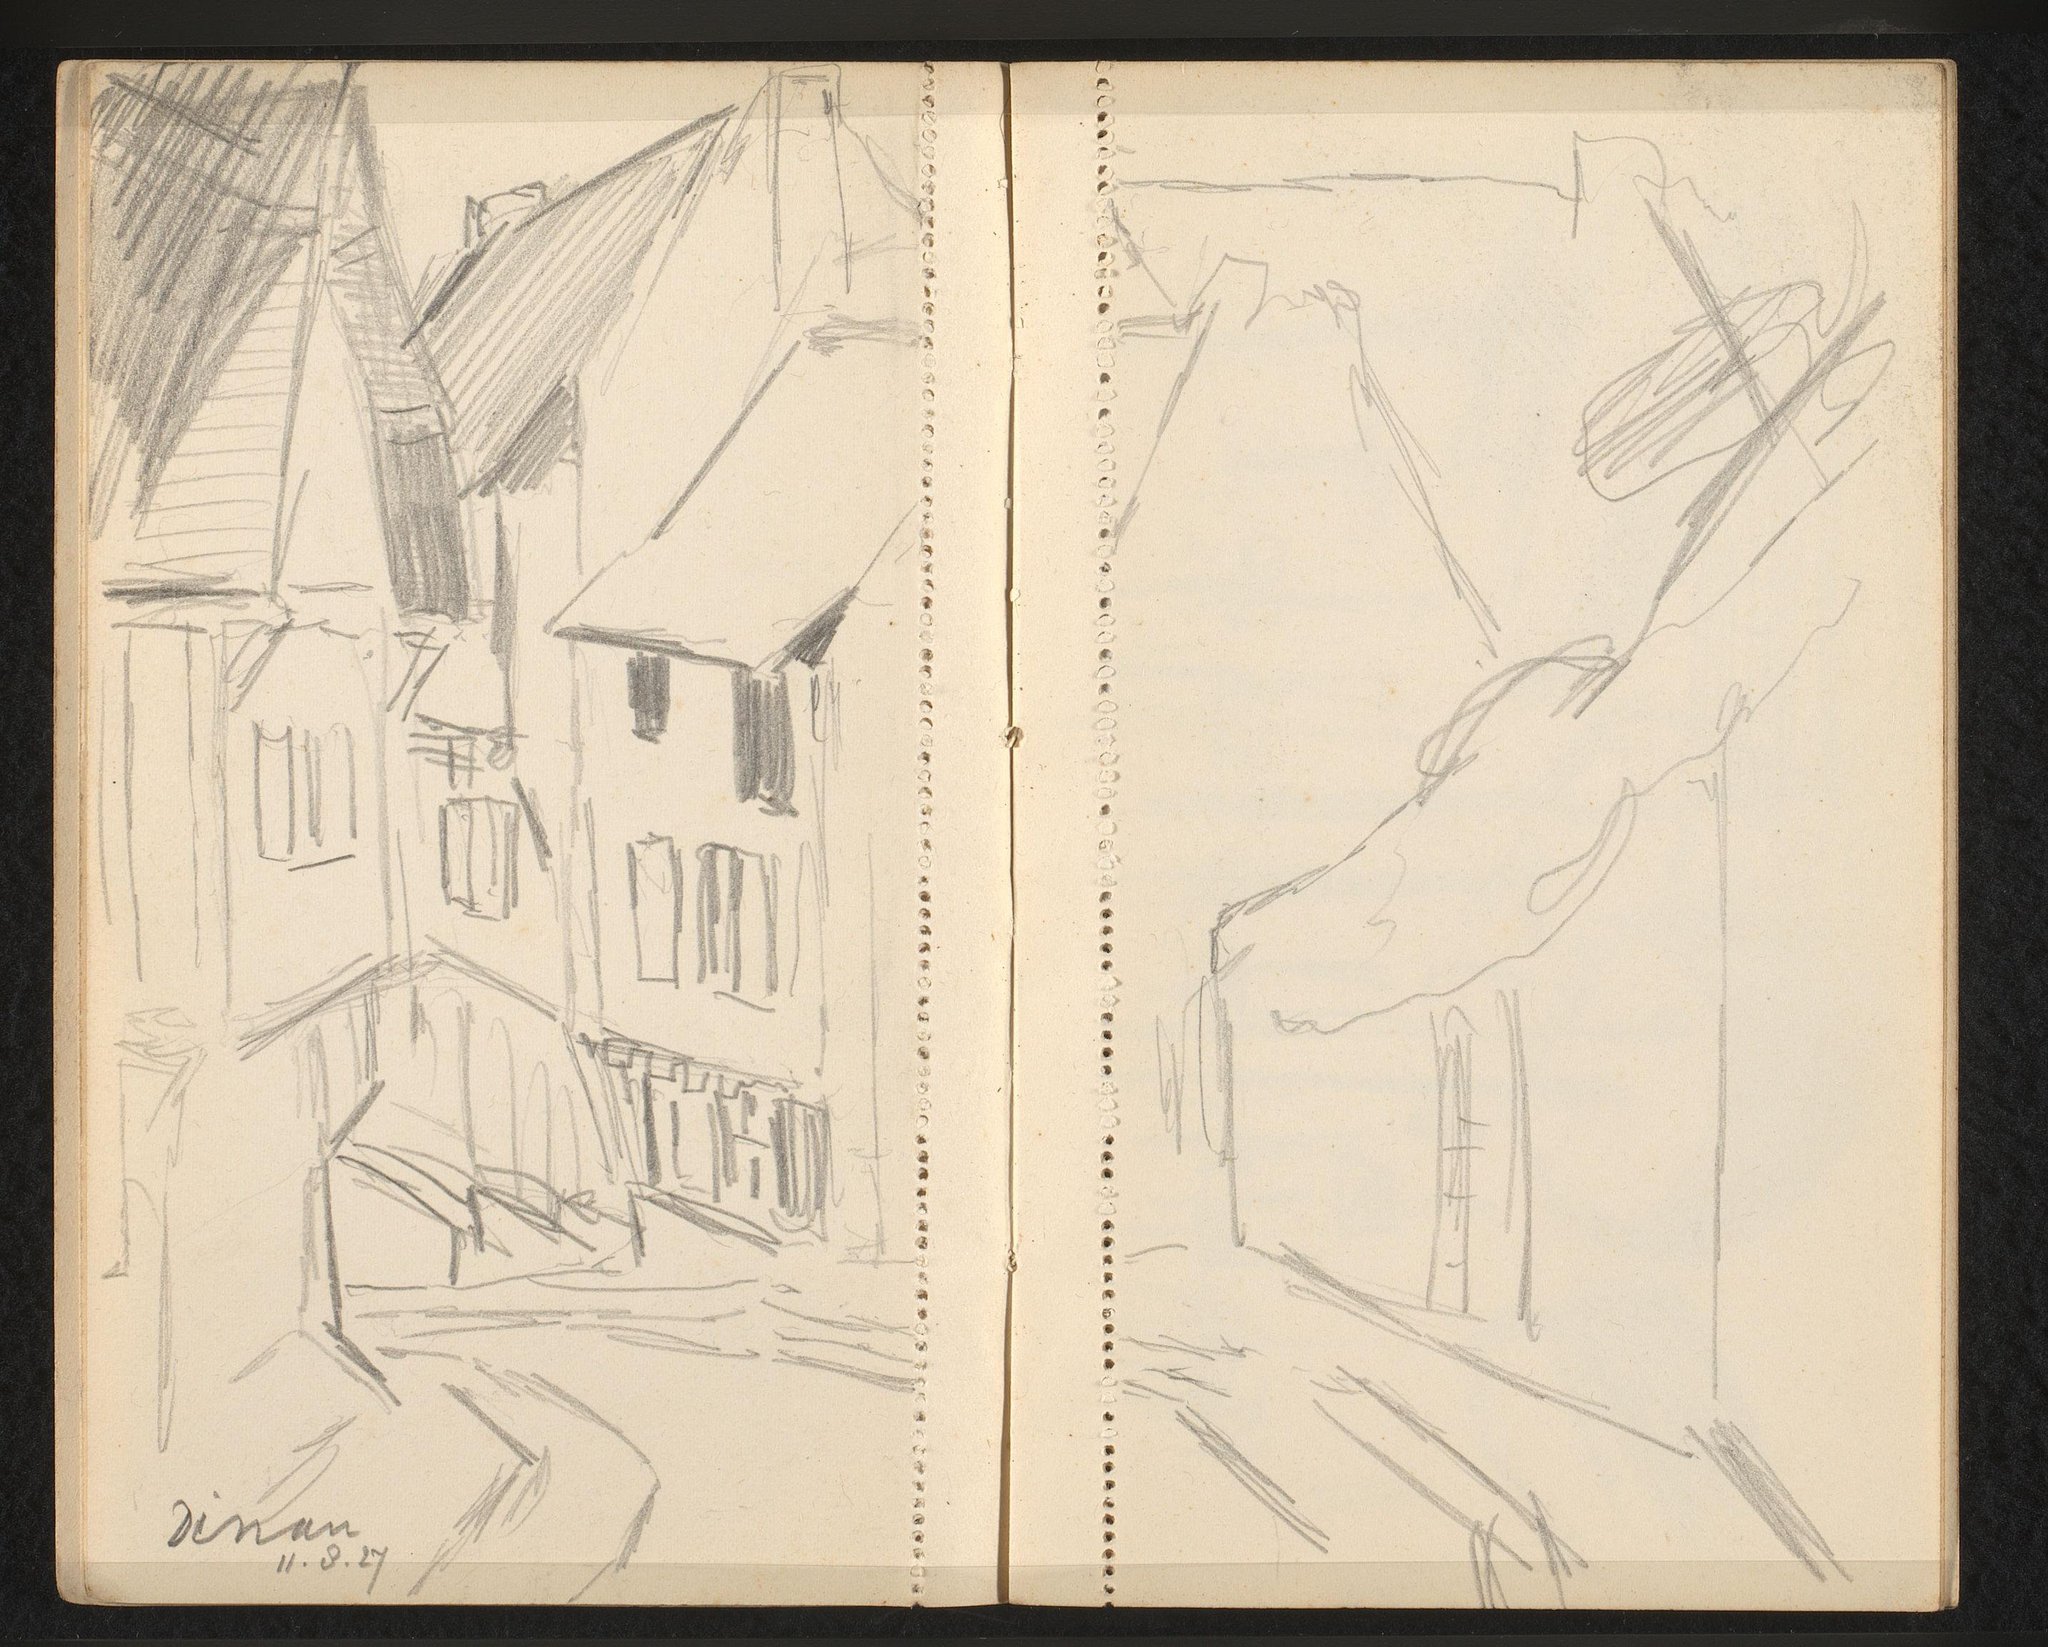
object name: sketchbook leaf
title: Straat te Dinan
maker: gerrit van blaaderen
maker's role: draughtsman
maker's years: 1873-1935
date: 1927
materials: paper, pencil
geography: dinan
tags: street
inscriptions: date and inscription: ‘Dinan/ 11.8.27’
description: Bladen 6 verso en 7 recto uit een schetsboek met 33 bladen.